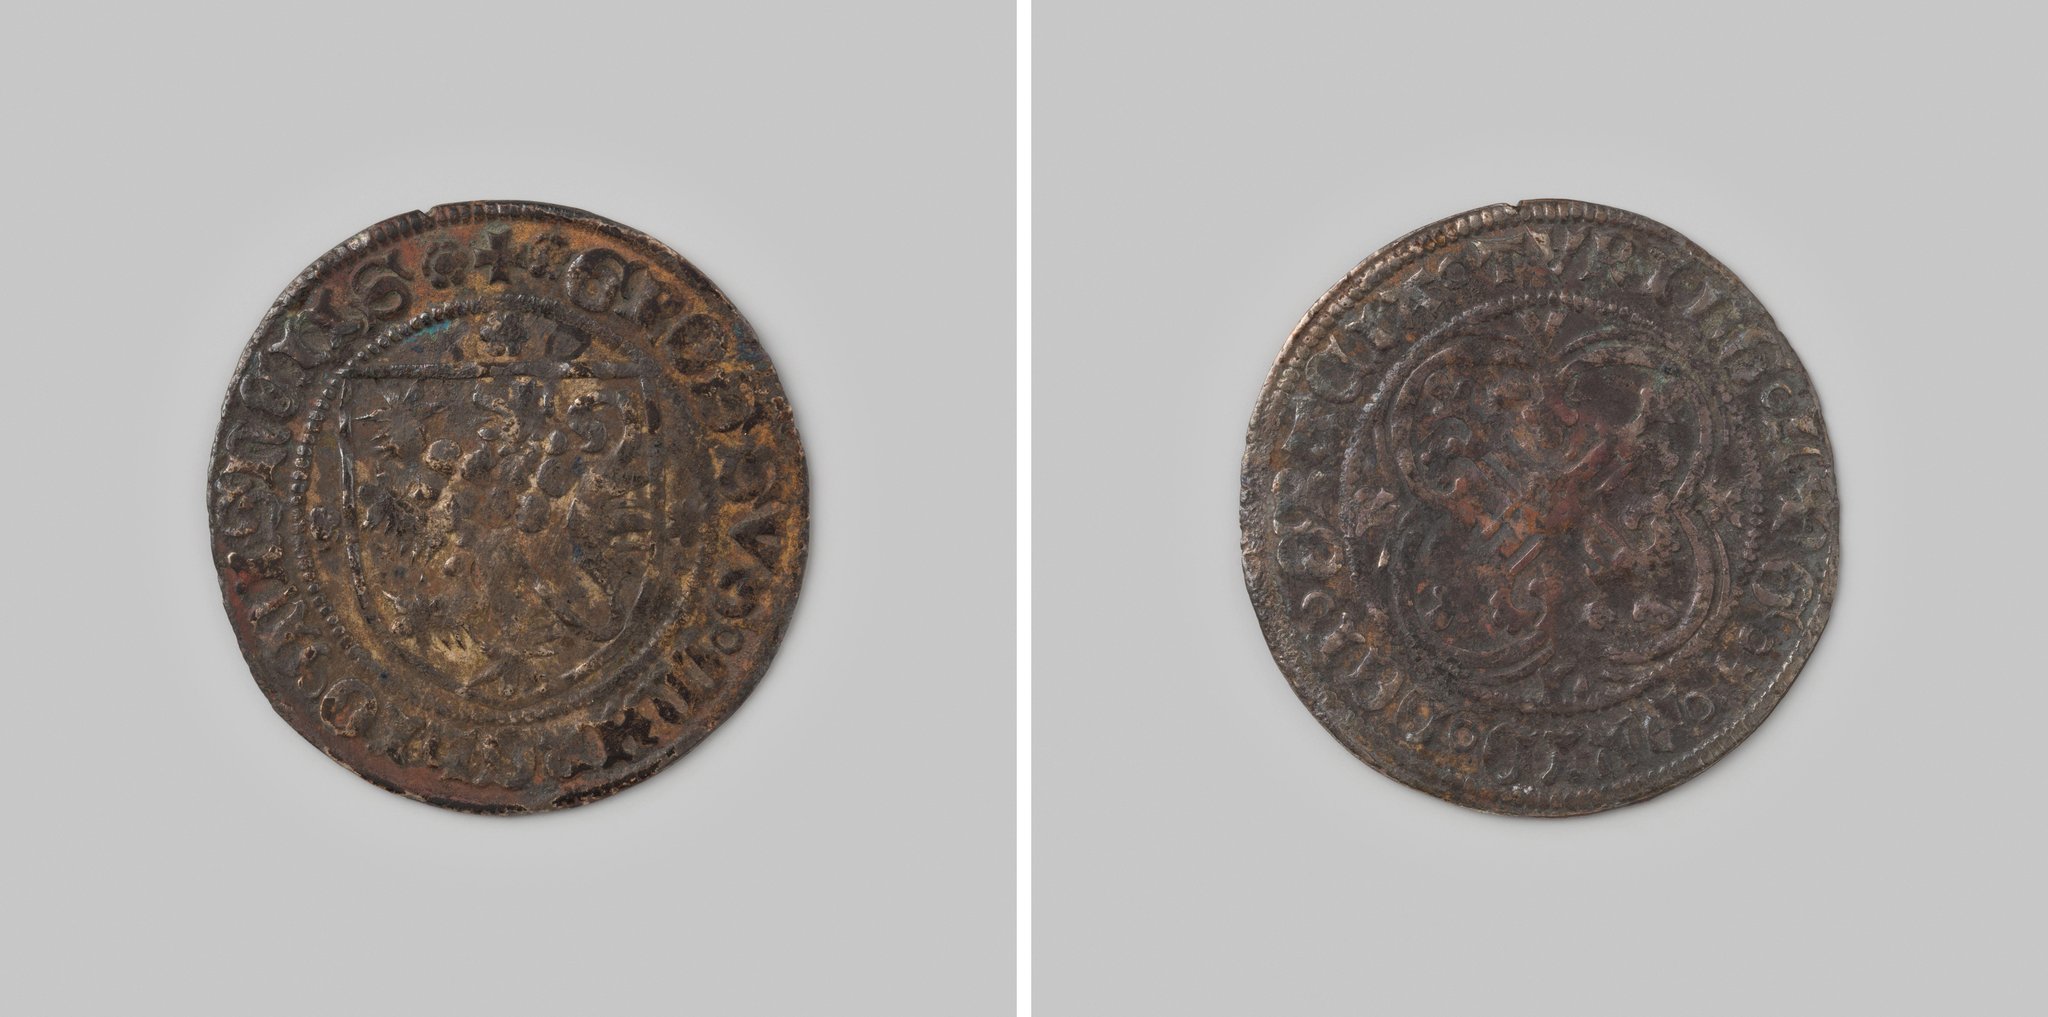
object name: coin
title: Saksen, Friedrich der Streitbare, ?-1428, Thüringer groschen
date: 1428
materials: silver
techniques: striking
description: Zilveren munt. Voorzijde: tussen drie rozetten wapenschild. Keerzijde: binnen versierde vierpas kort gebloemd kruis.